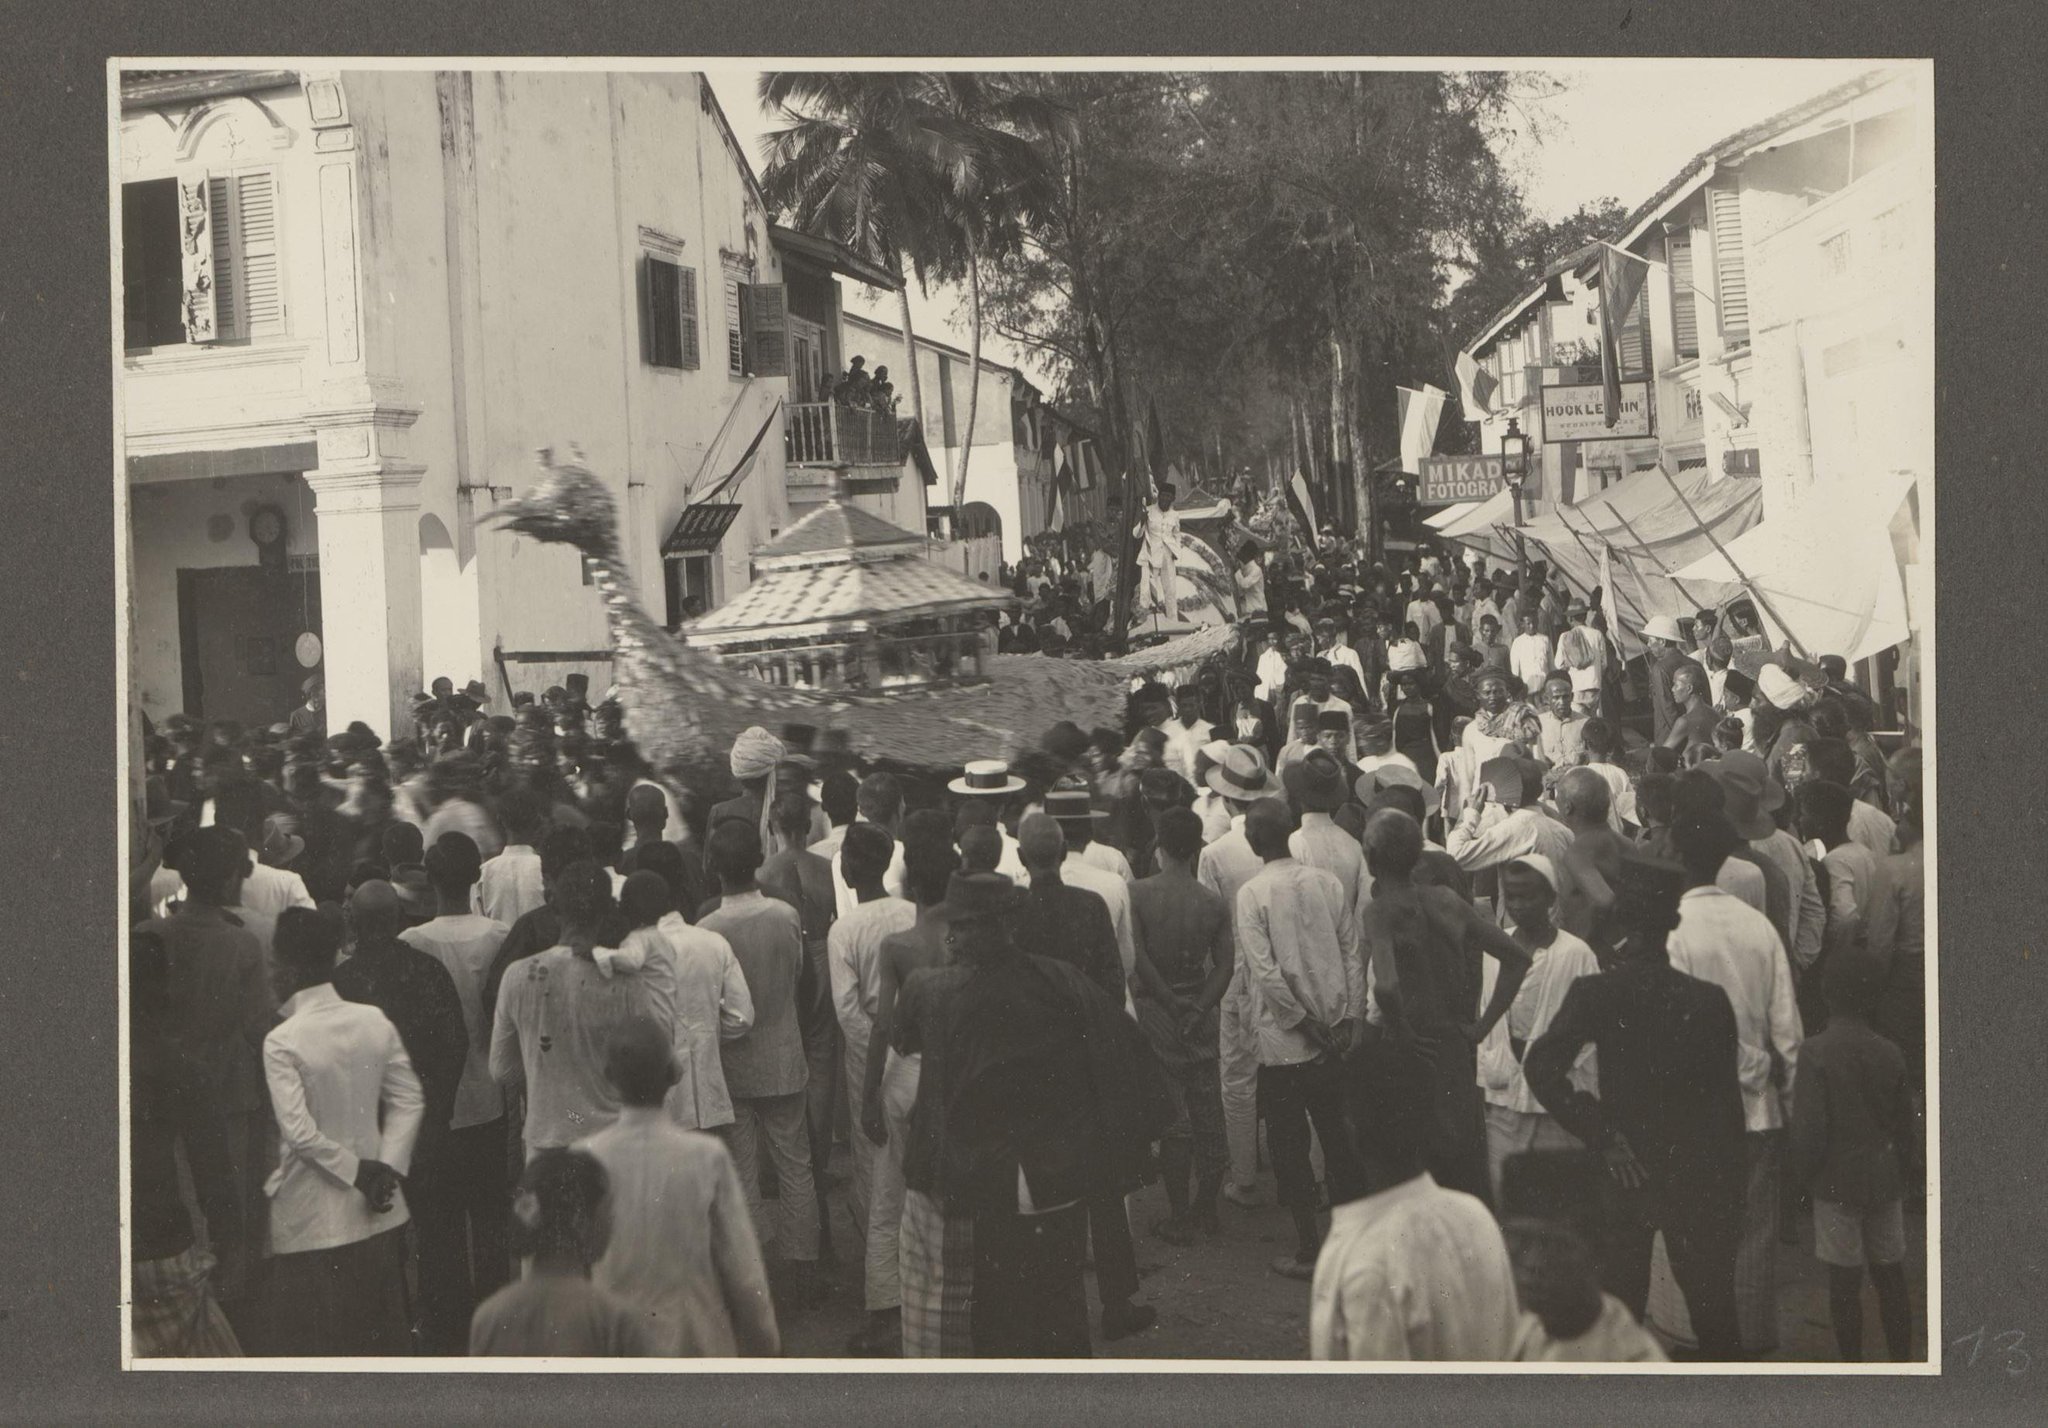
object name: photograph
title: Optocht met praalwagens in de straten van hoofdstad van provincie Langkat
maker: Anonymous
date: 1919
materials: photographic support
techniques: gelatin silver print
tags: float ~ triumph, historical persons, public festivities, sumatra